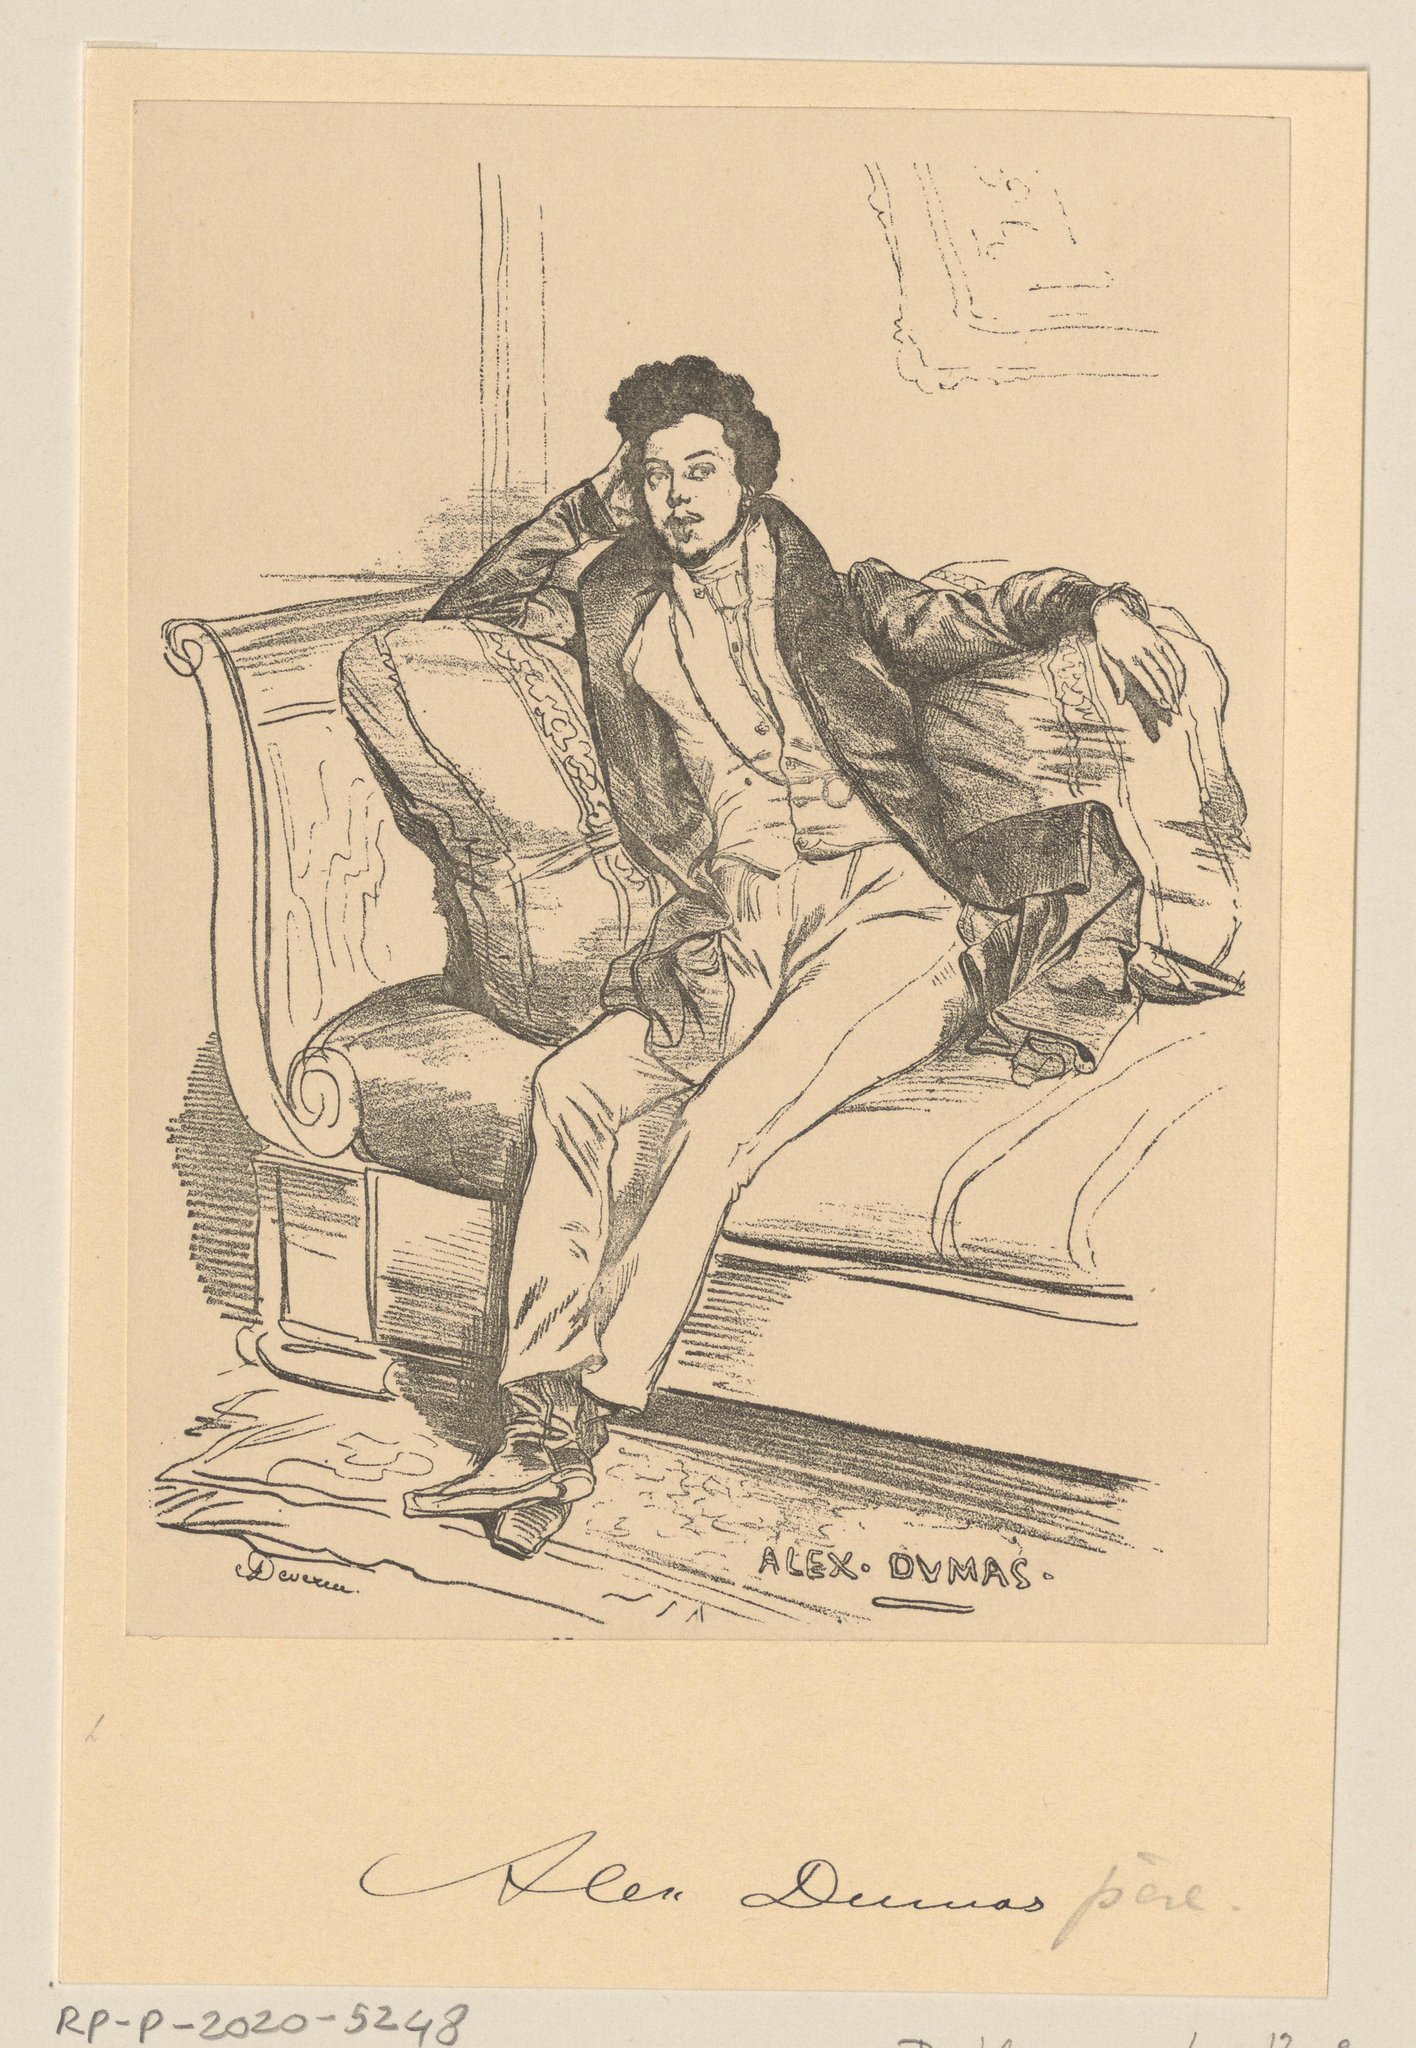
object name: photomechanical print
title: Portret van Alexandre Dumas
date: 1880-1949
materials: paper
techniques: photochemical processes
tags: historical persons, portrait of a writer, couch, sofa, settee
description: Zittend op een sofa met linkerarm leunend op een kussen en zijn rechterhand achter het hoofd.